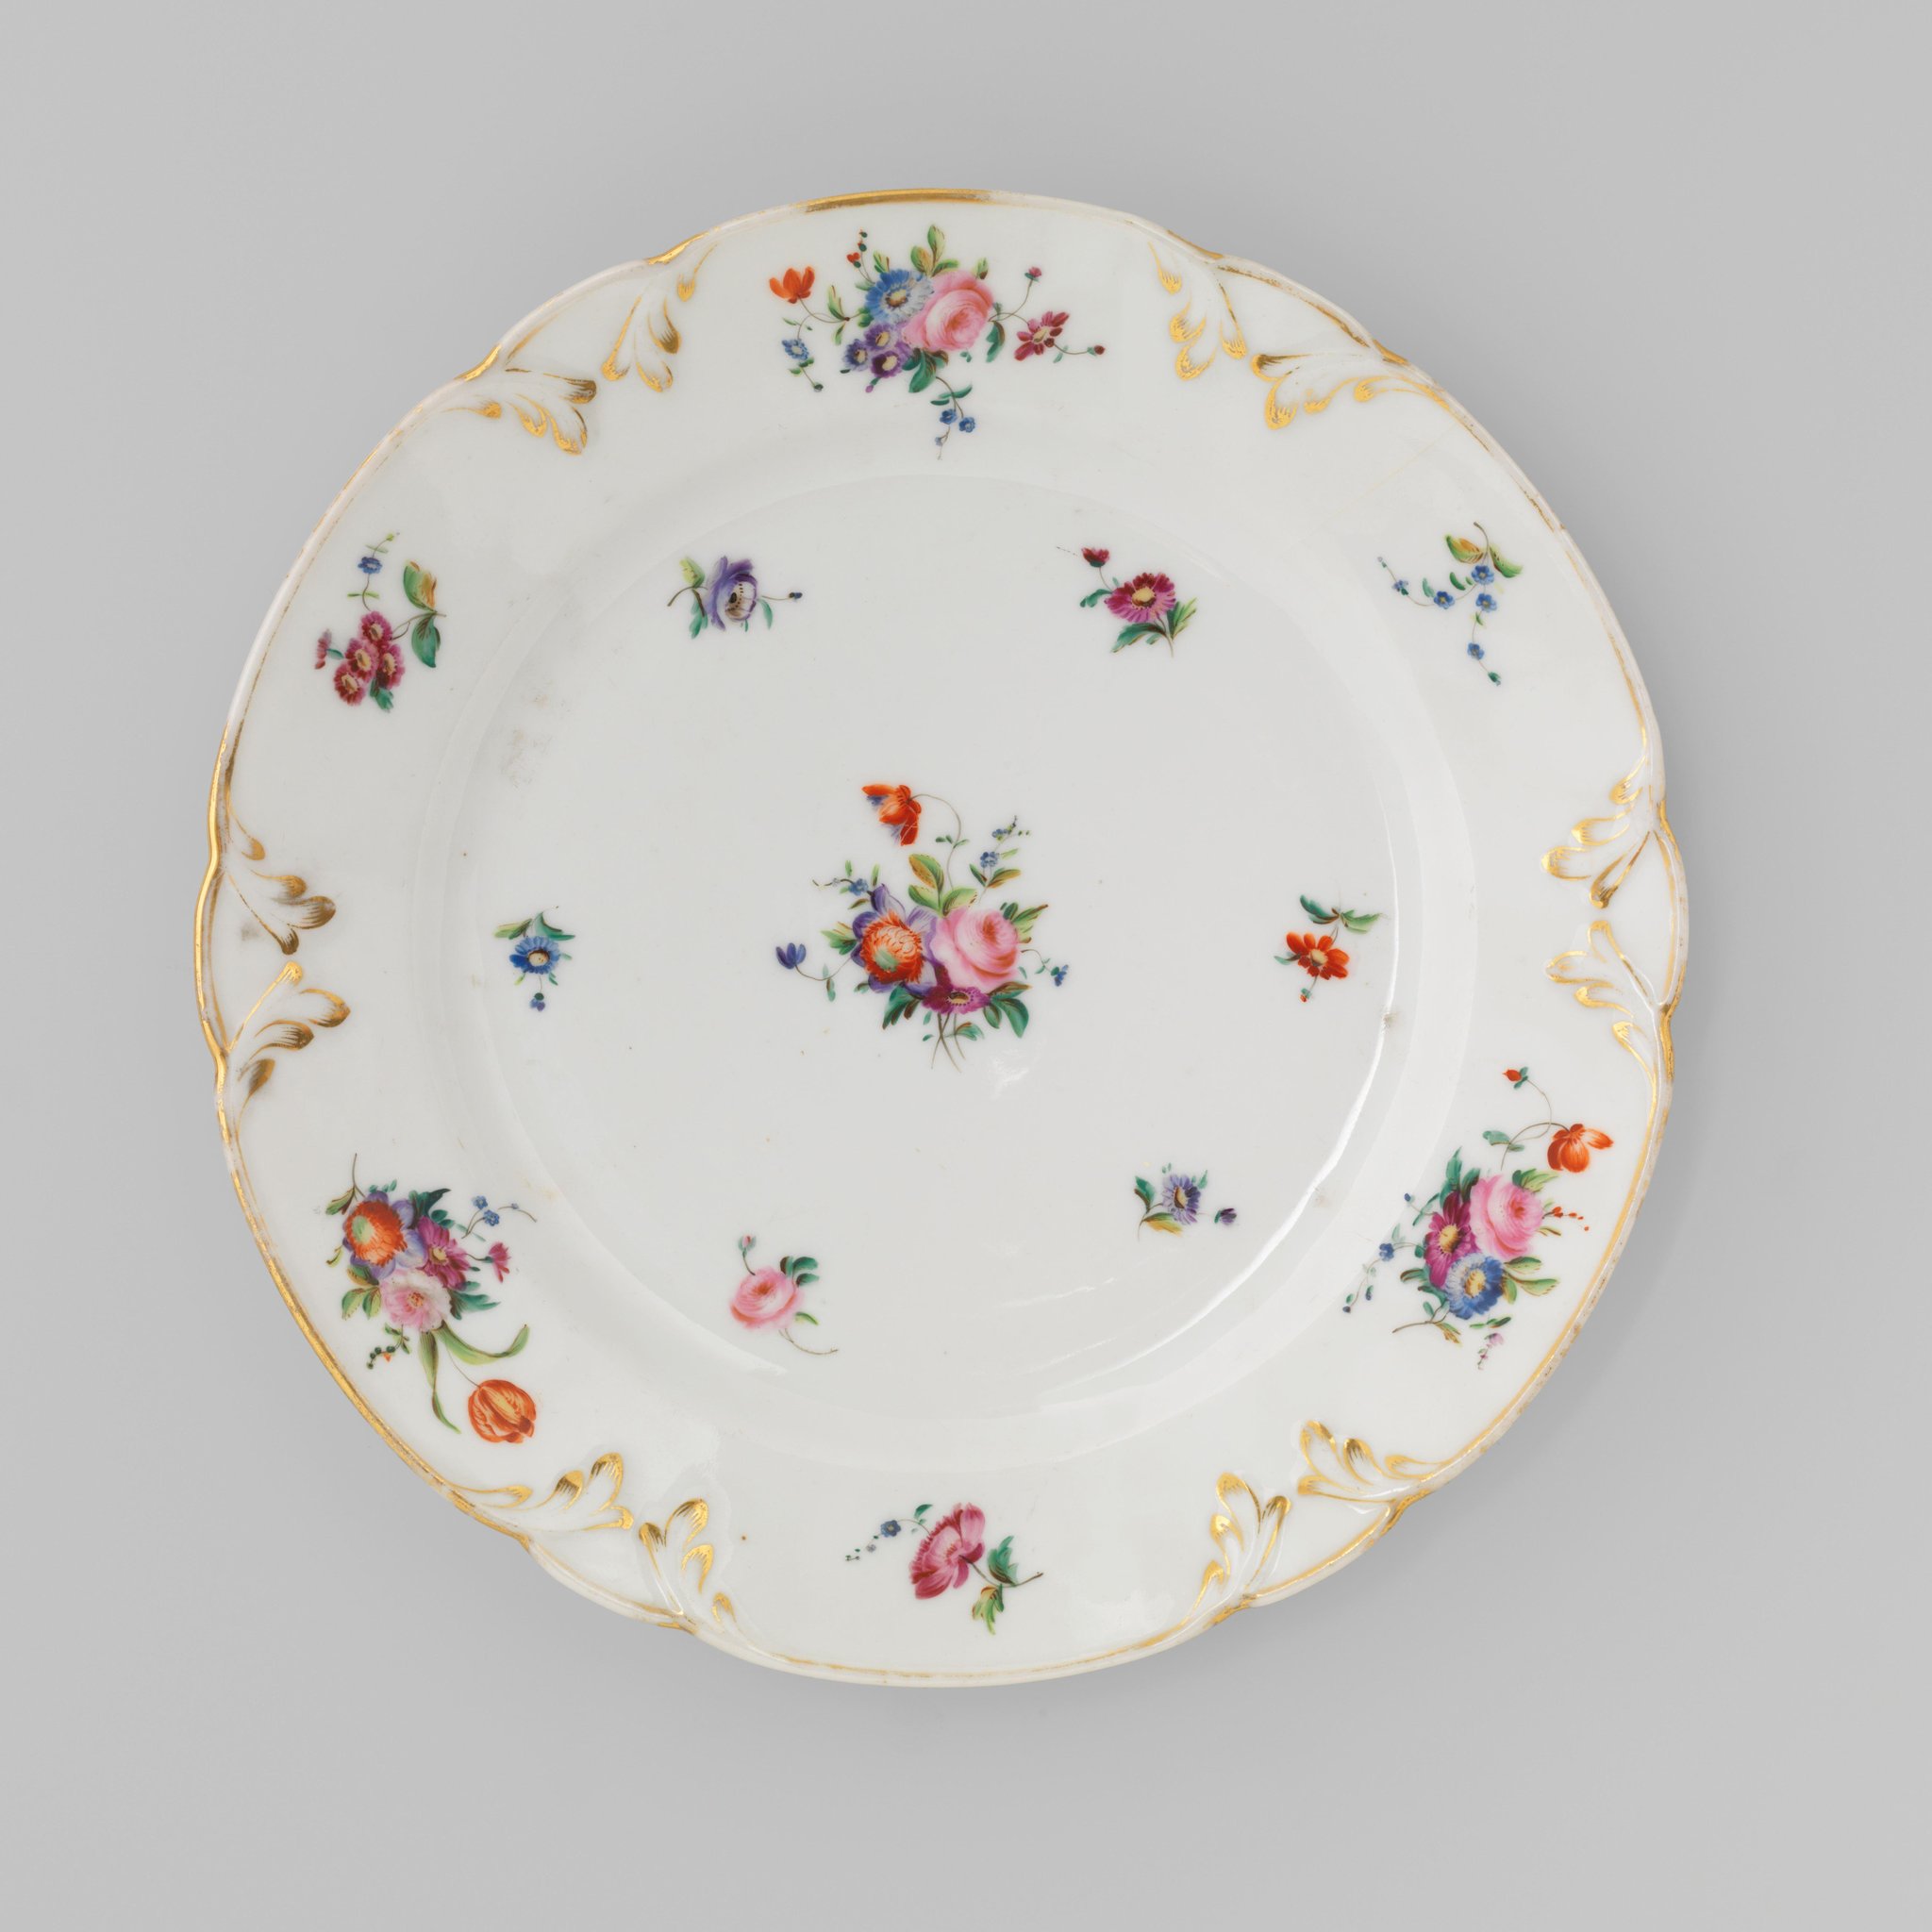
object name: plate dish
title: Plate with bouquets and flower sprays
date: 1839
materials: glaze, gold, paint, porcelain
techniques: firing, forming, gilding, turning, vitrification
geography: paris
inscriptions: mark: ‘DENUELLE/ Boulevard St. Denis 18/ à Paris’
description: Bord van porselein met een gelobde rand, beschilderd op het glazuur in blauw, rood, roze, groen, geel, paars, zwart en goud. Op het plat boeketten van verschillende bloemen en strooibloemen. Vanuit de gelobde, gouden rand, gemodelleerde bladranken in reliëf, aangezet met goud. Hiertussen boeketten. Drie proenen op de onderzijde. Gemerkt op de onderzijde met 'DENUELLE/ Boulevard St. Denis 18/ à Paris'.